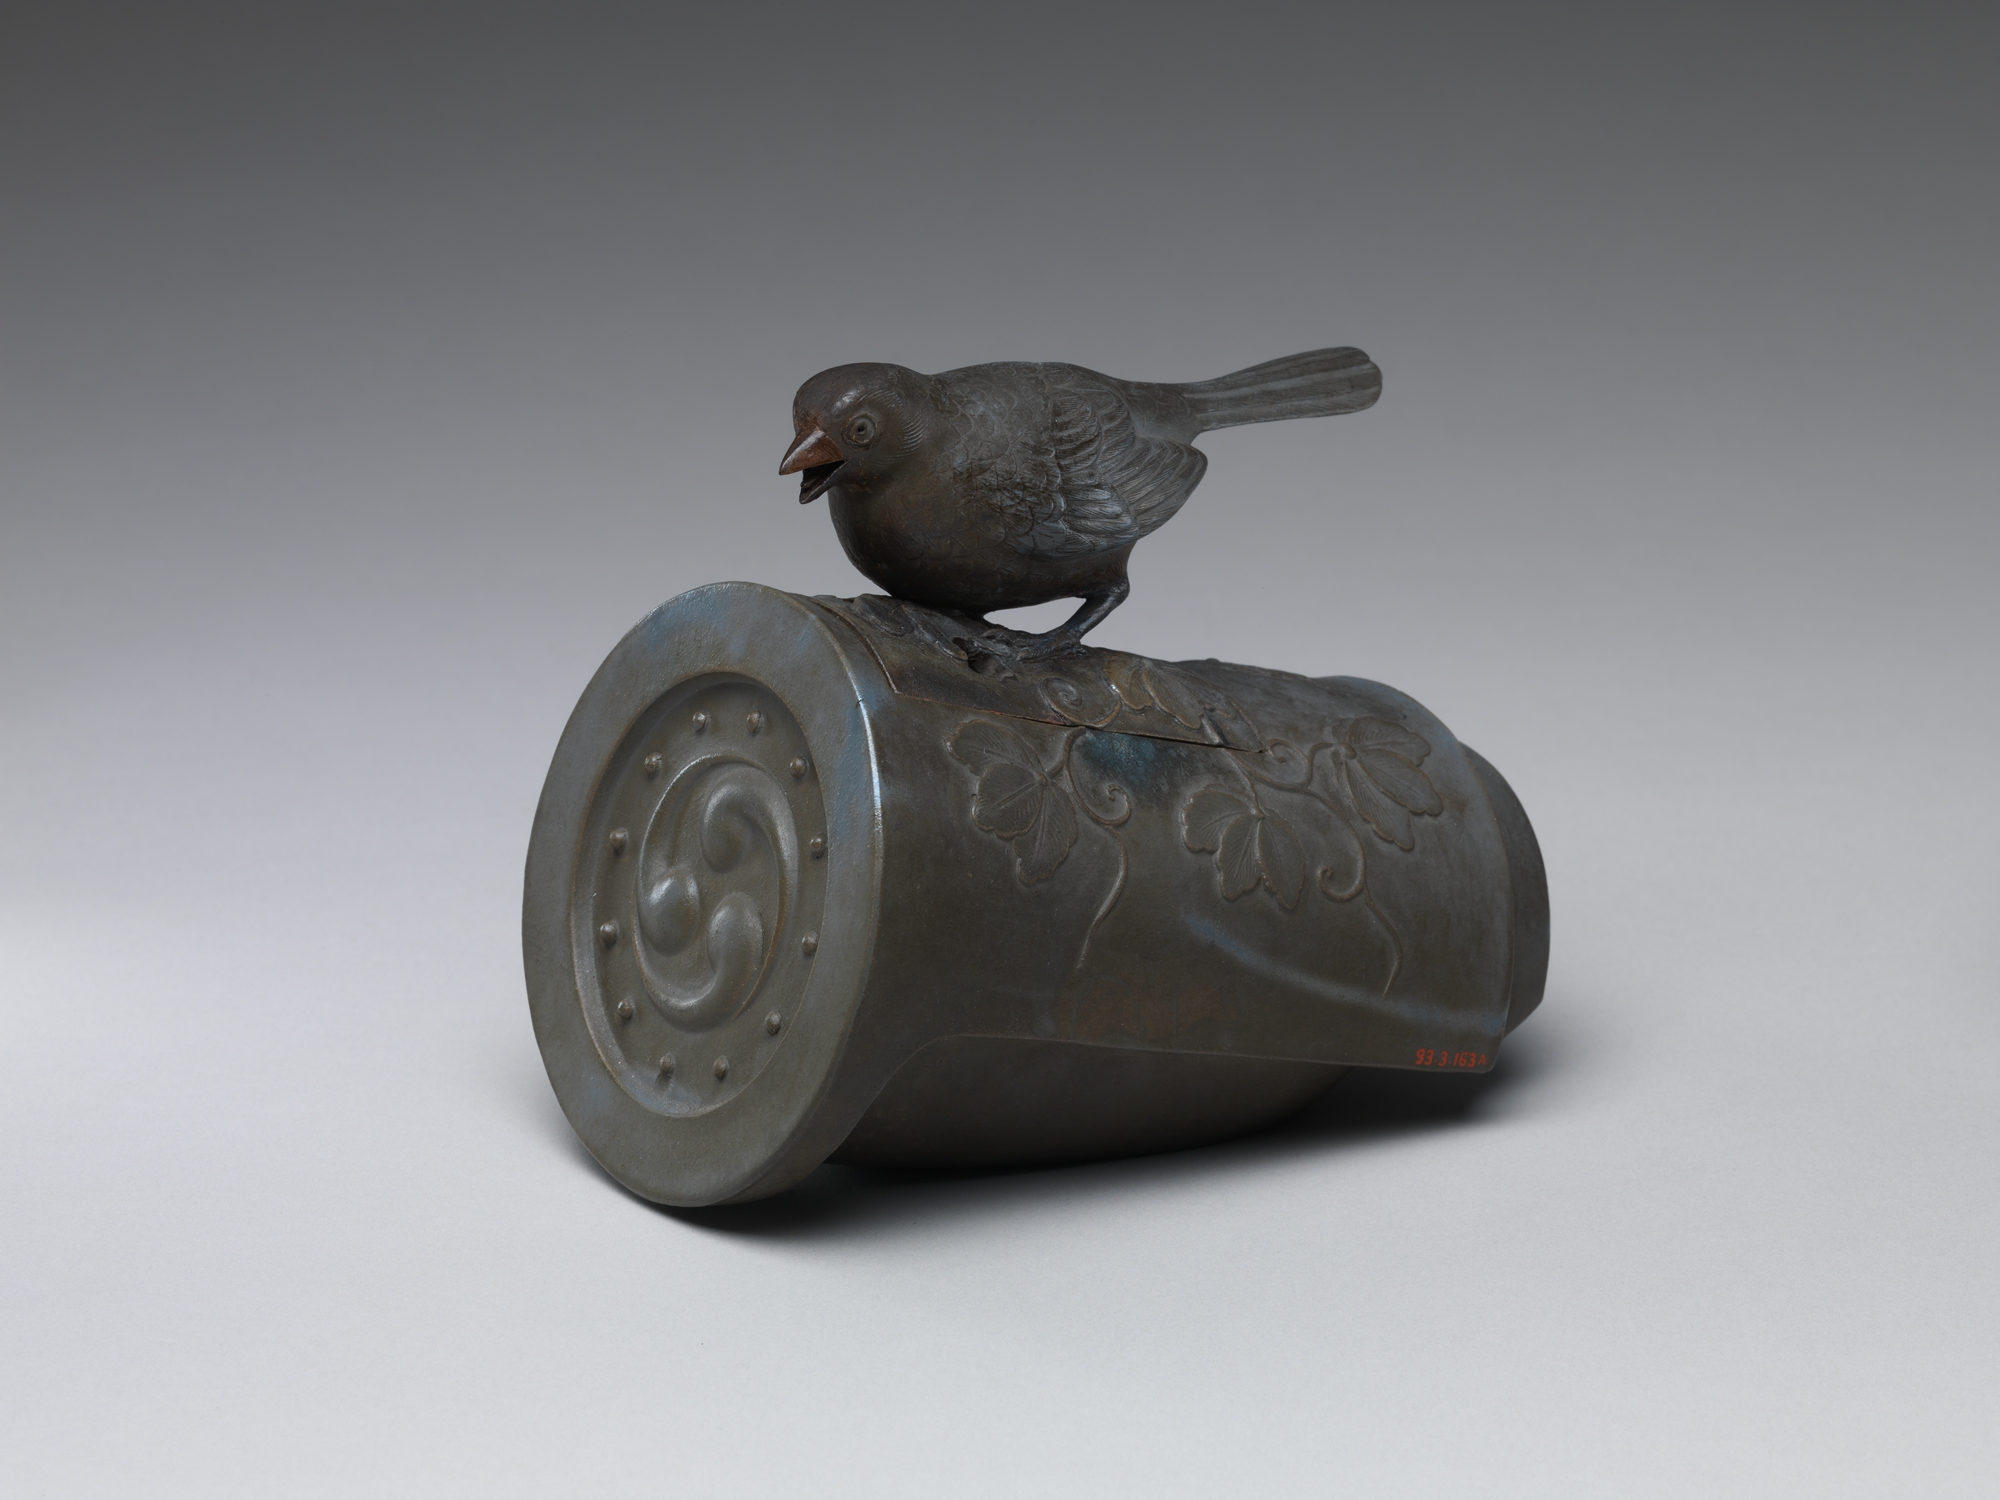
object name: censer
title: Censer in the Form of Sparrow on a Roof Tile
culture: japanese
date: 1650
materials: stoneware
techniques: glazing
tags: birds,censers